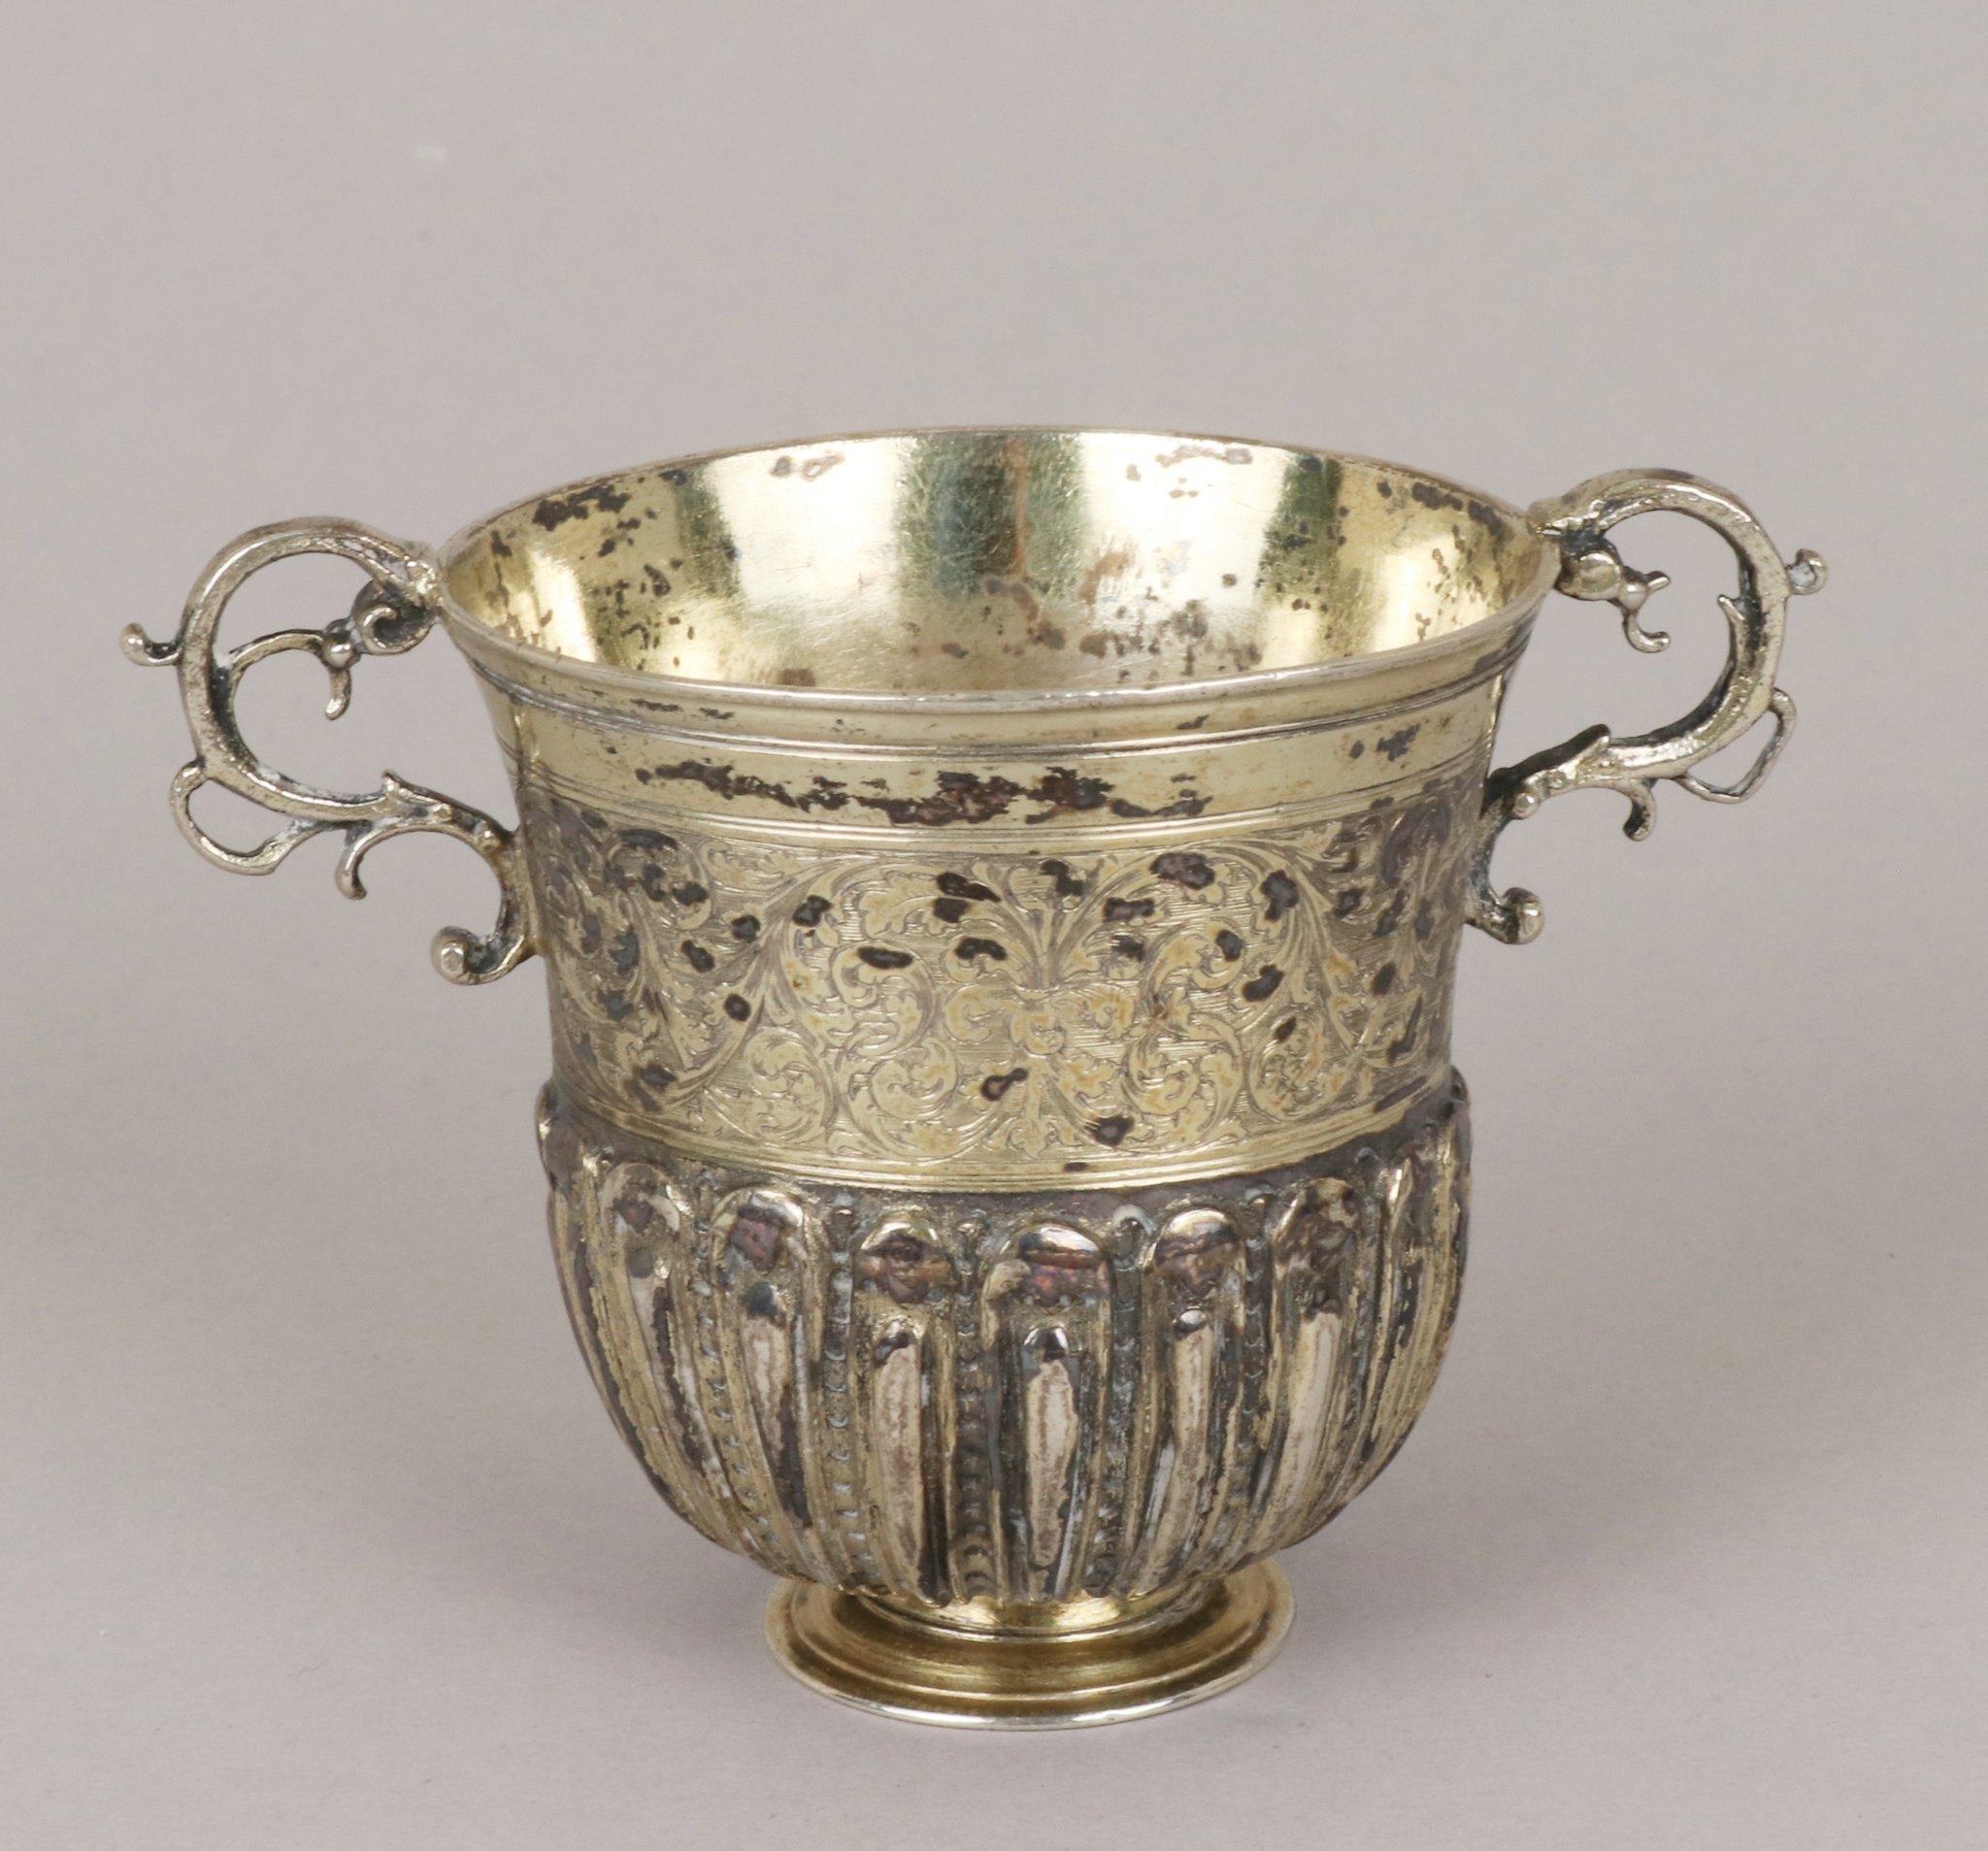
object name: cup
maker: elias adam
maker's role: maker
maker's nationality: german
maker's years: 1669-1745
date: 1701-1733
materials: silver gilt